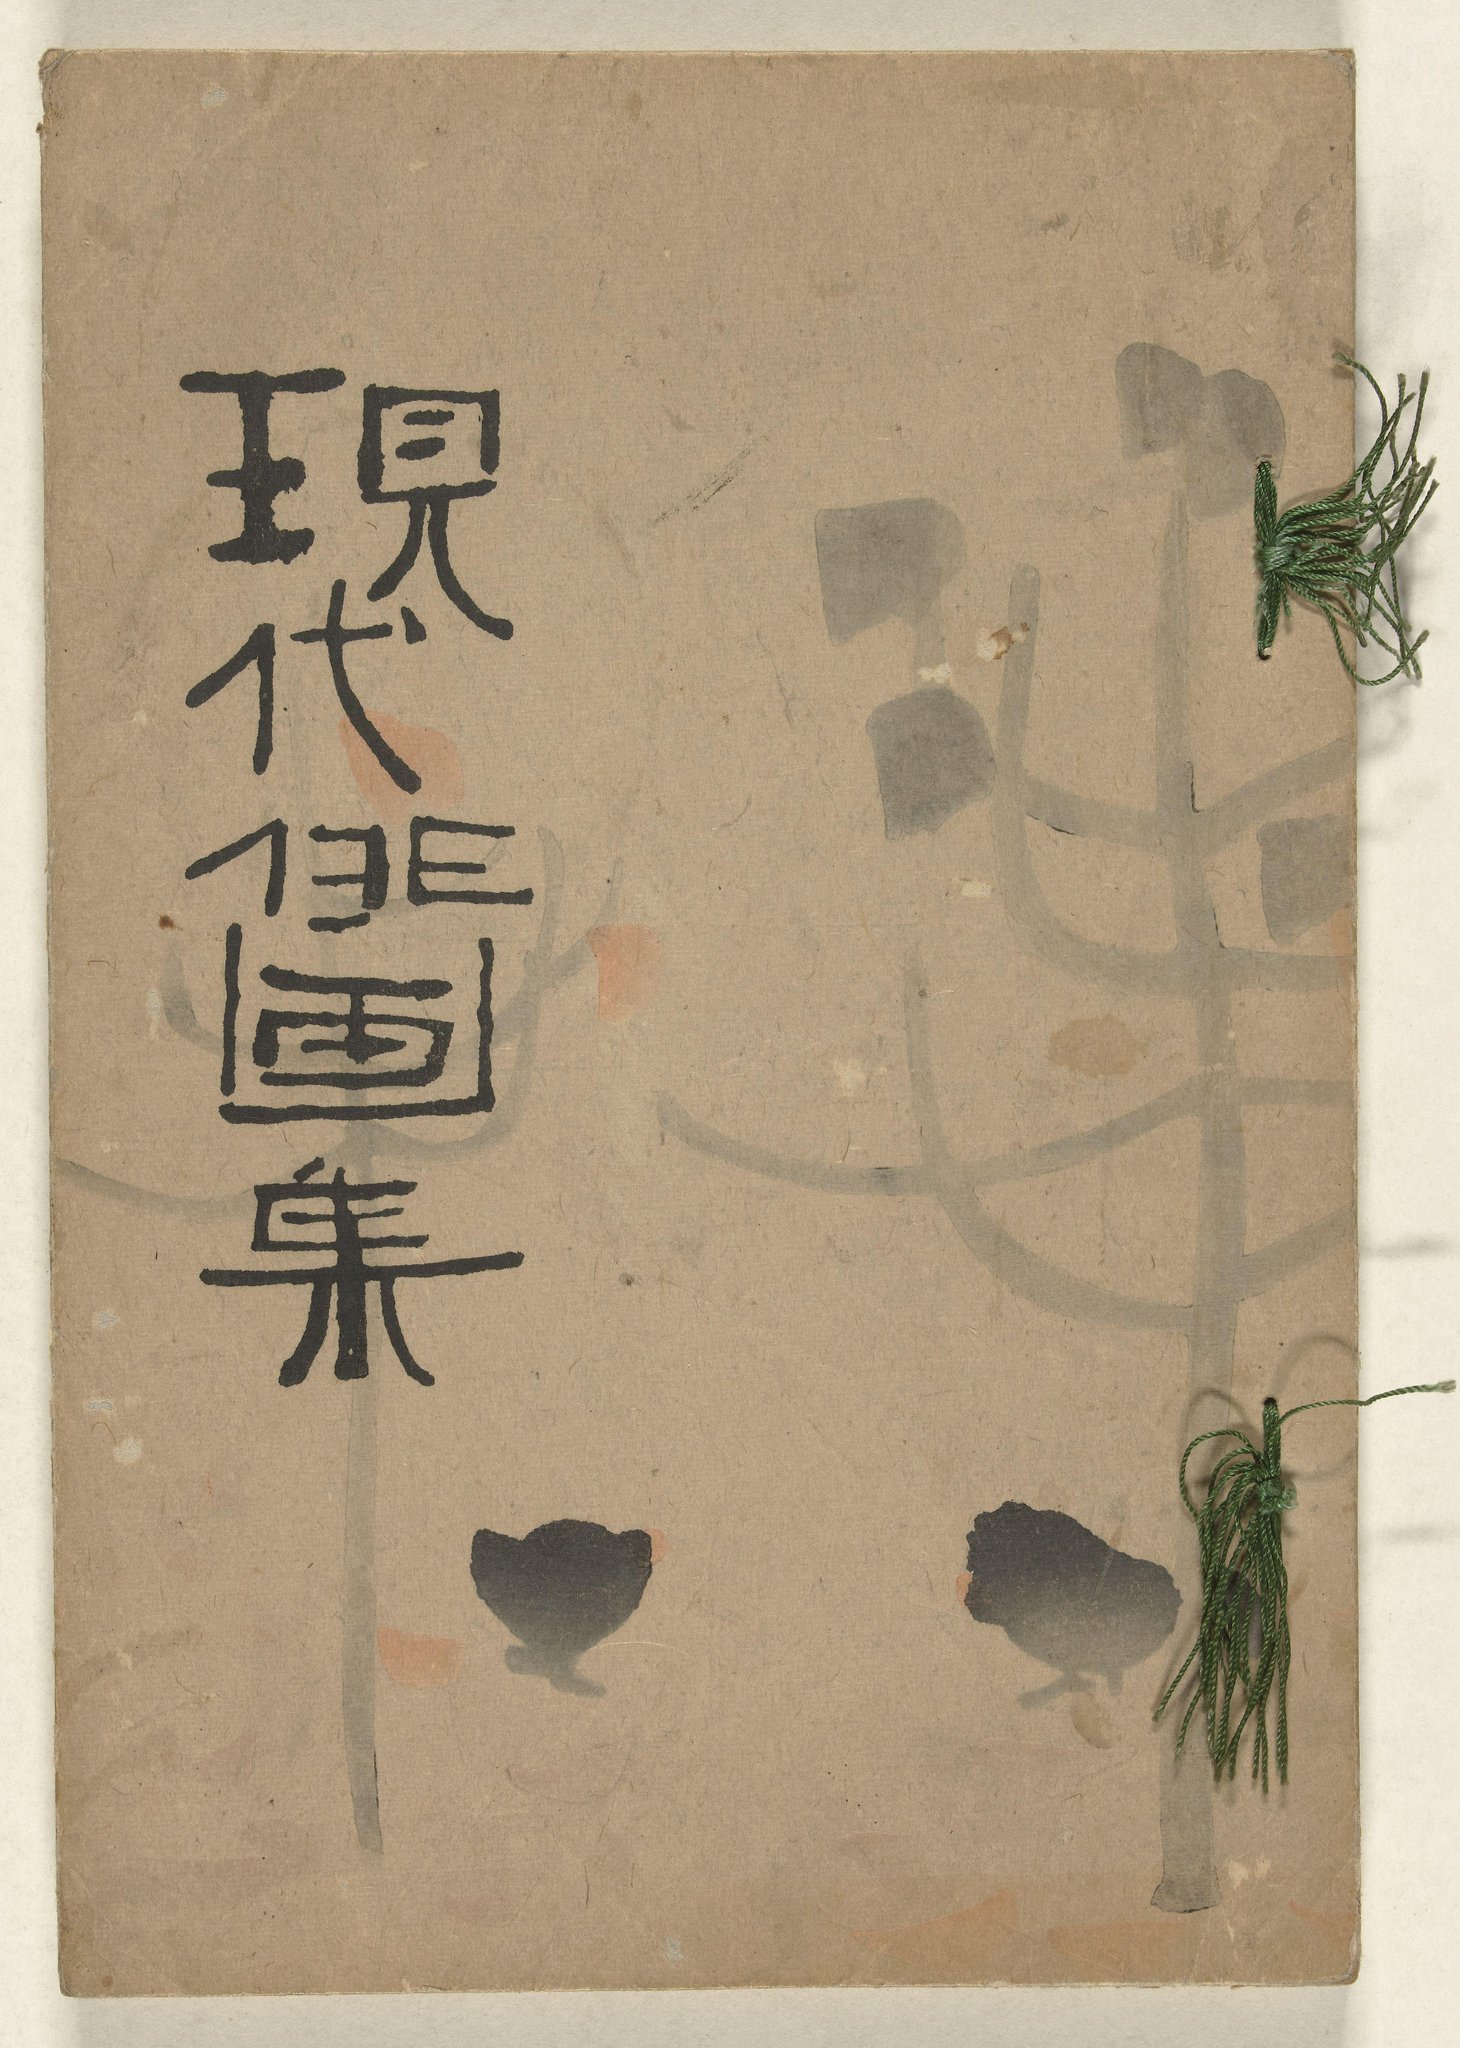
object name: book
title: Verzameling moderne snelle tekeningen - Herfst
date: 1904-1917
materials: paper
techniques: woodcut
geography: tokyo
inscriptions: date